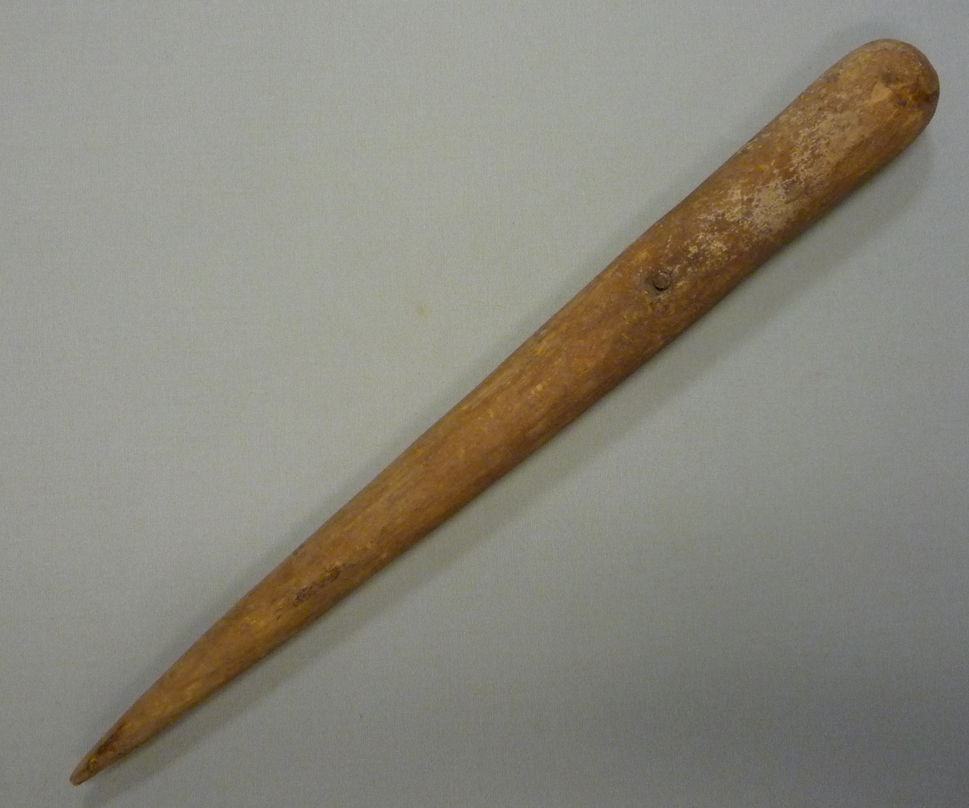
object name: peg, ritual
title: Ritual Peg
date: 1479-1458 BCE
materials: wood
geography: egypt